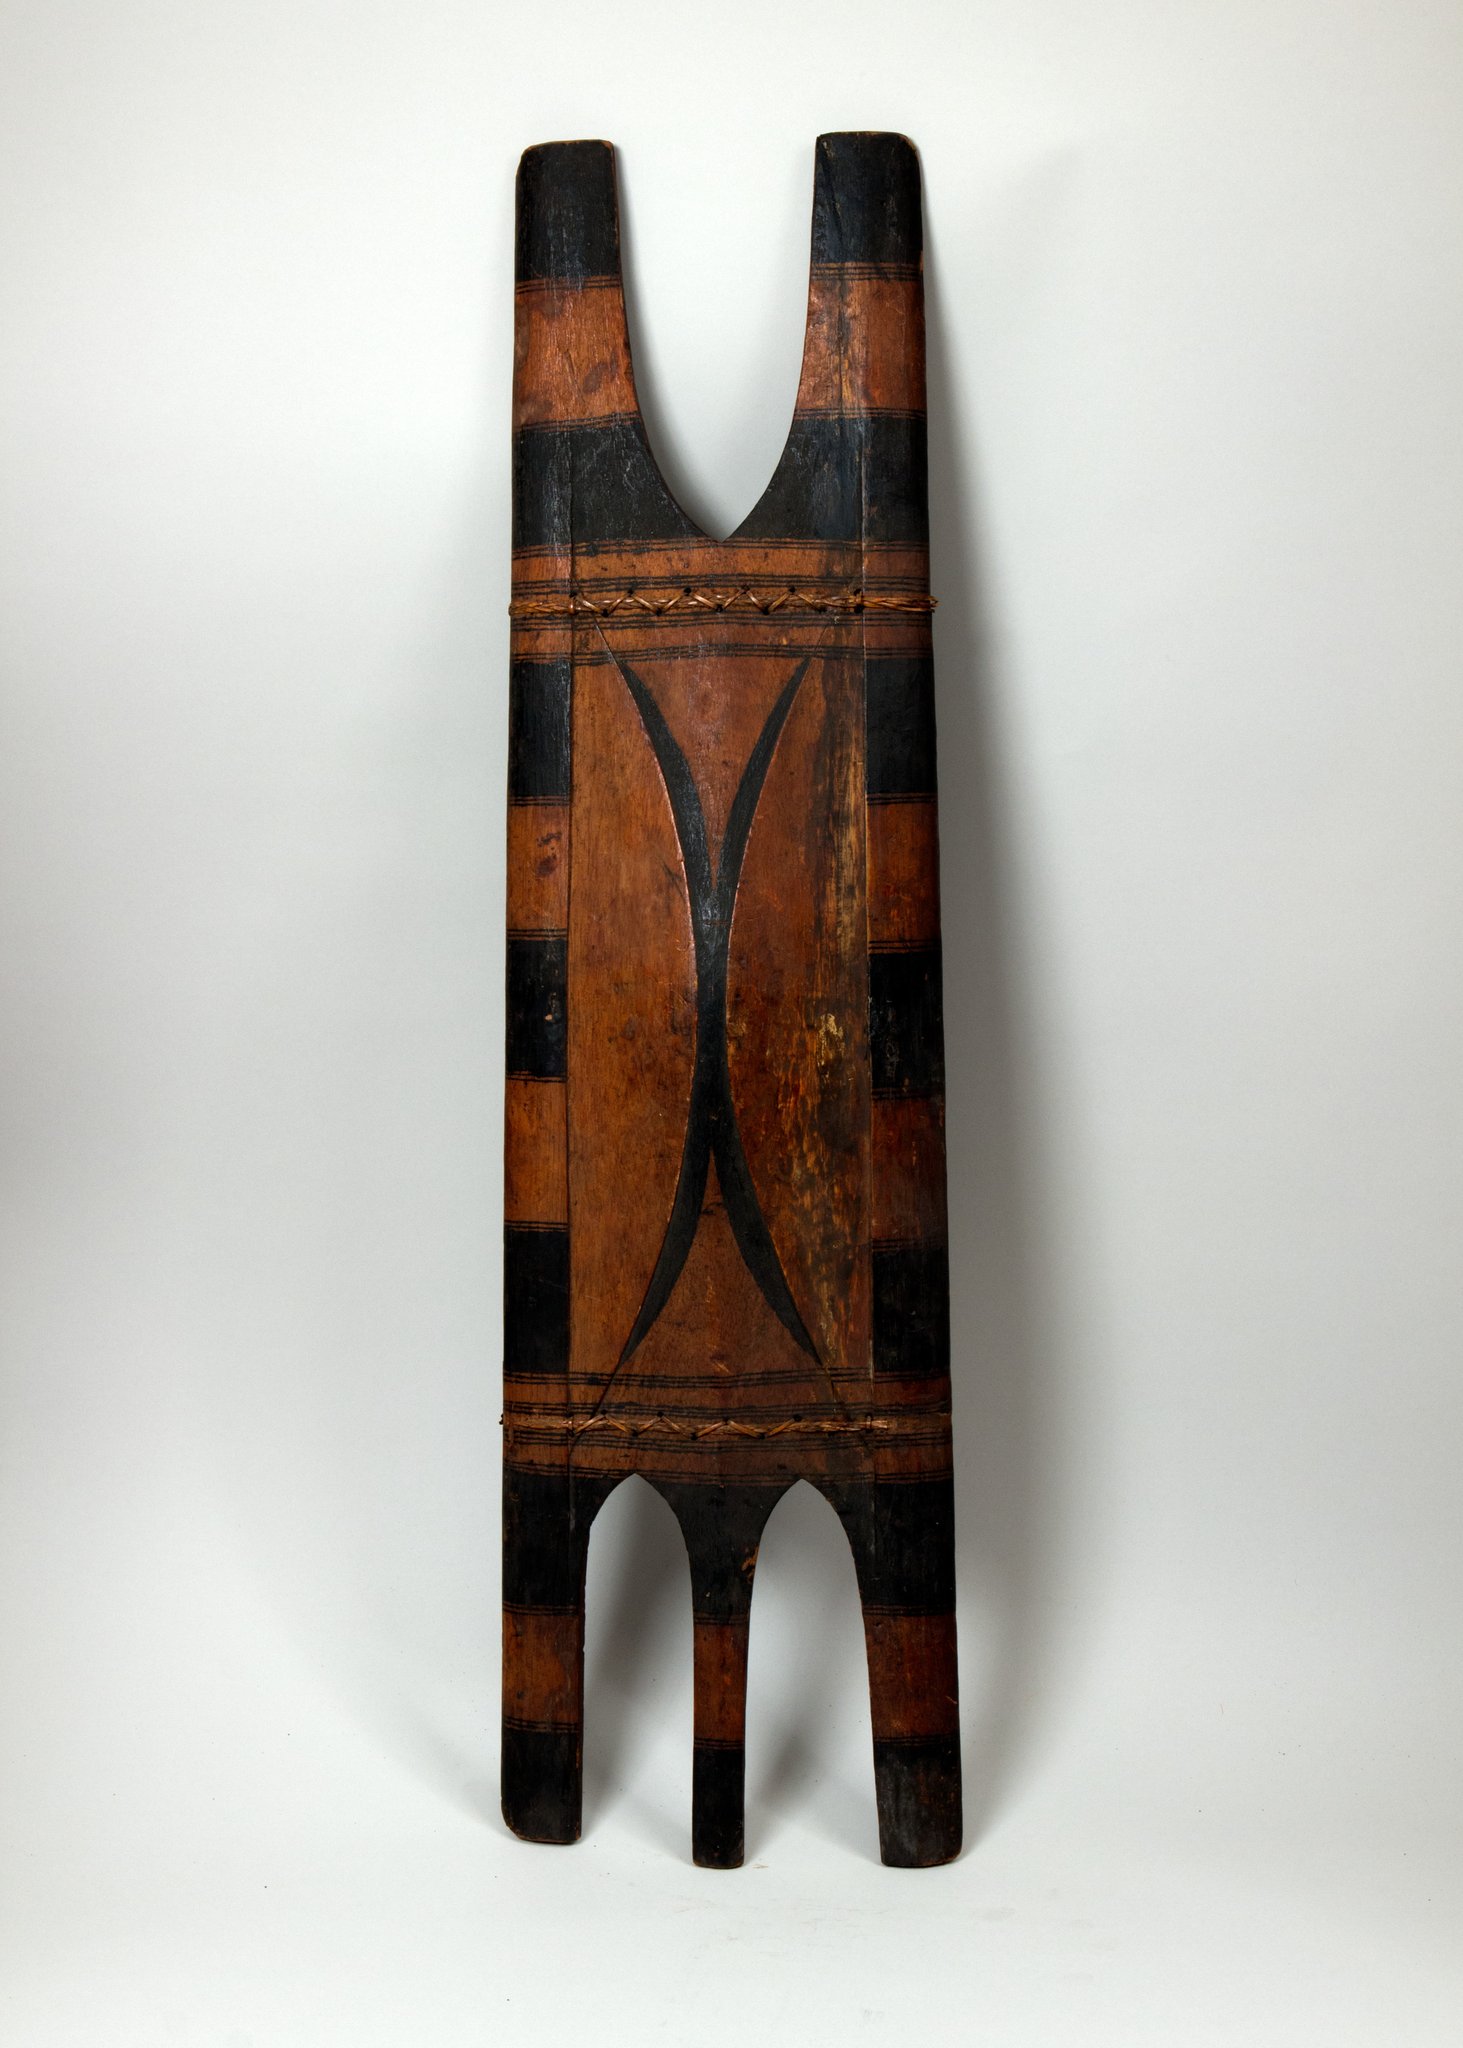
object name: shield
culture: philippine or igorot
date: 1701-1900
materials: rattan, wood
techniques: polychromy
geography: philippines